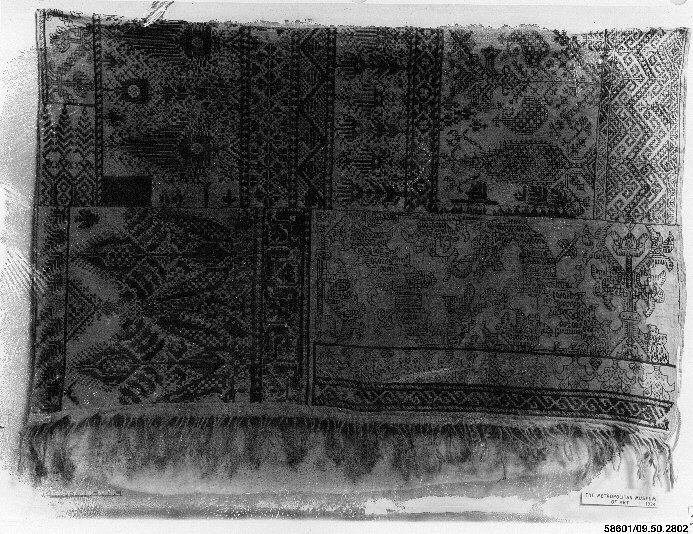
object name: sampler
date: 1701-1800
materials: linen, silk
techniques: embroidery, weave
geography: morocco